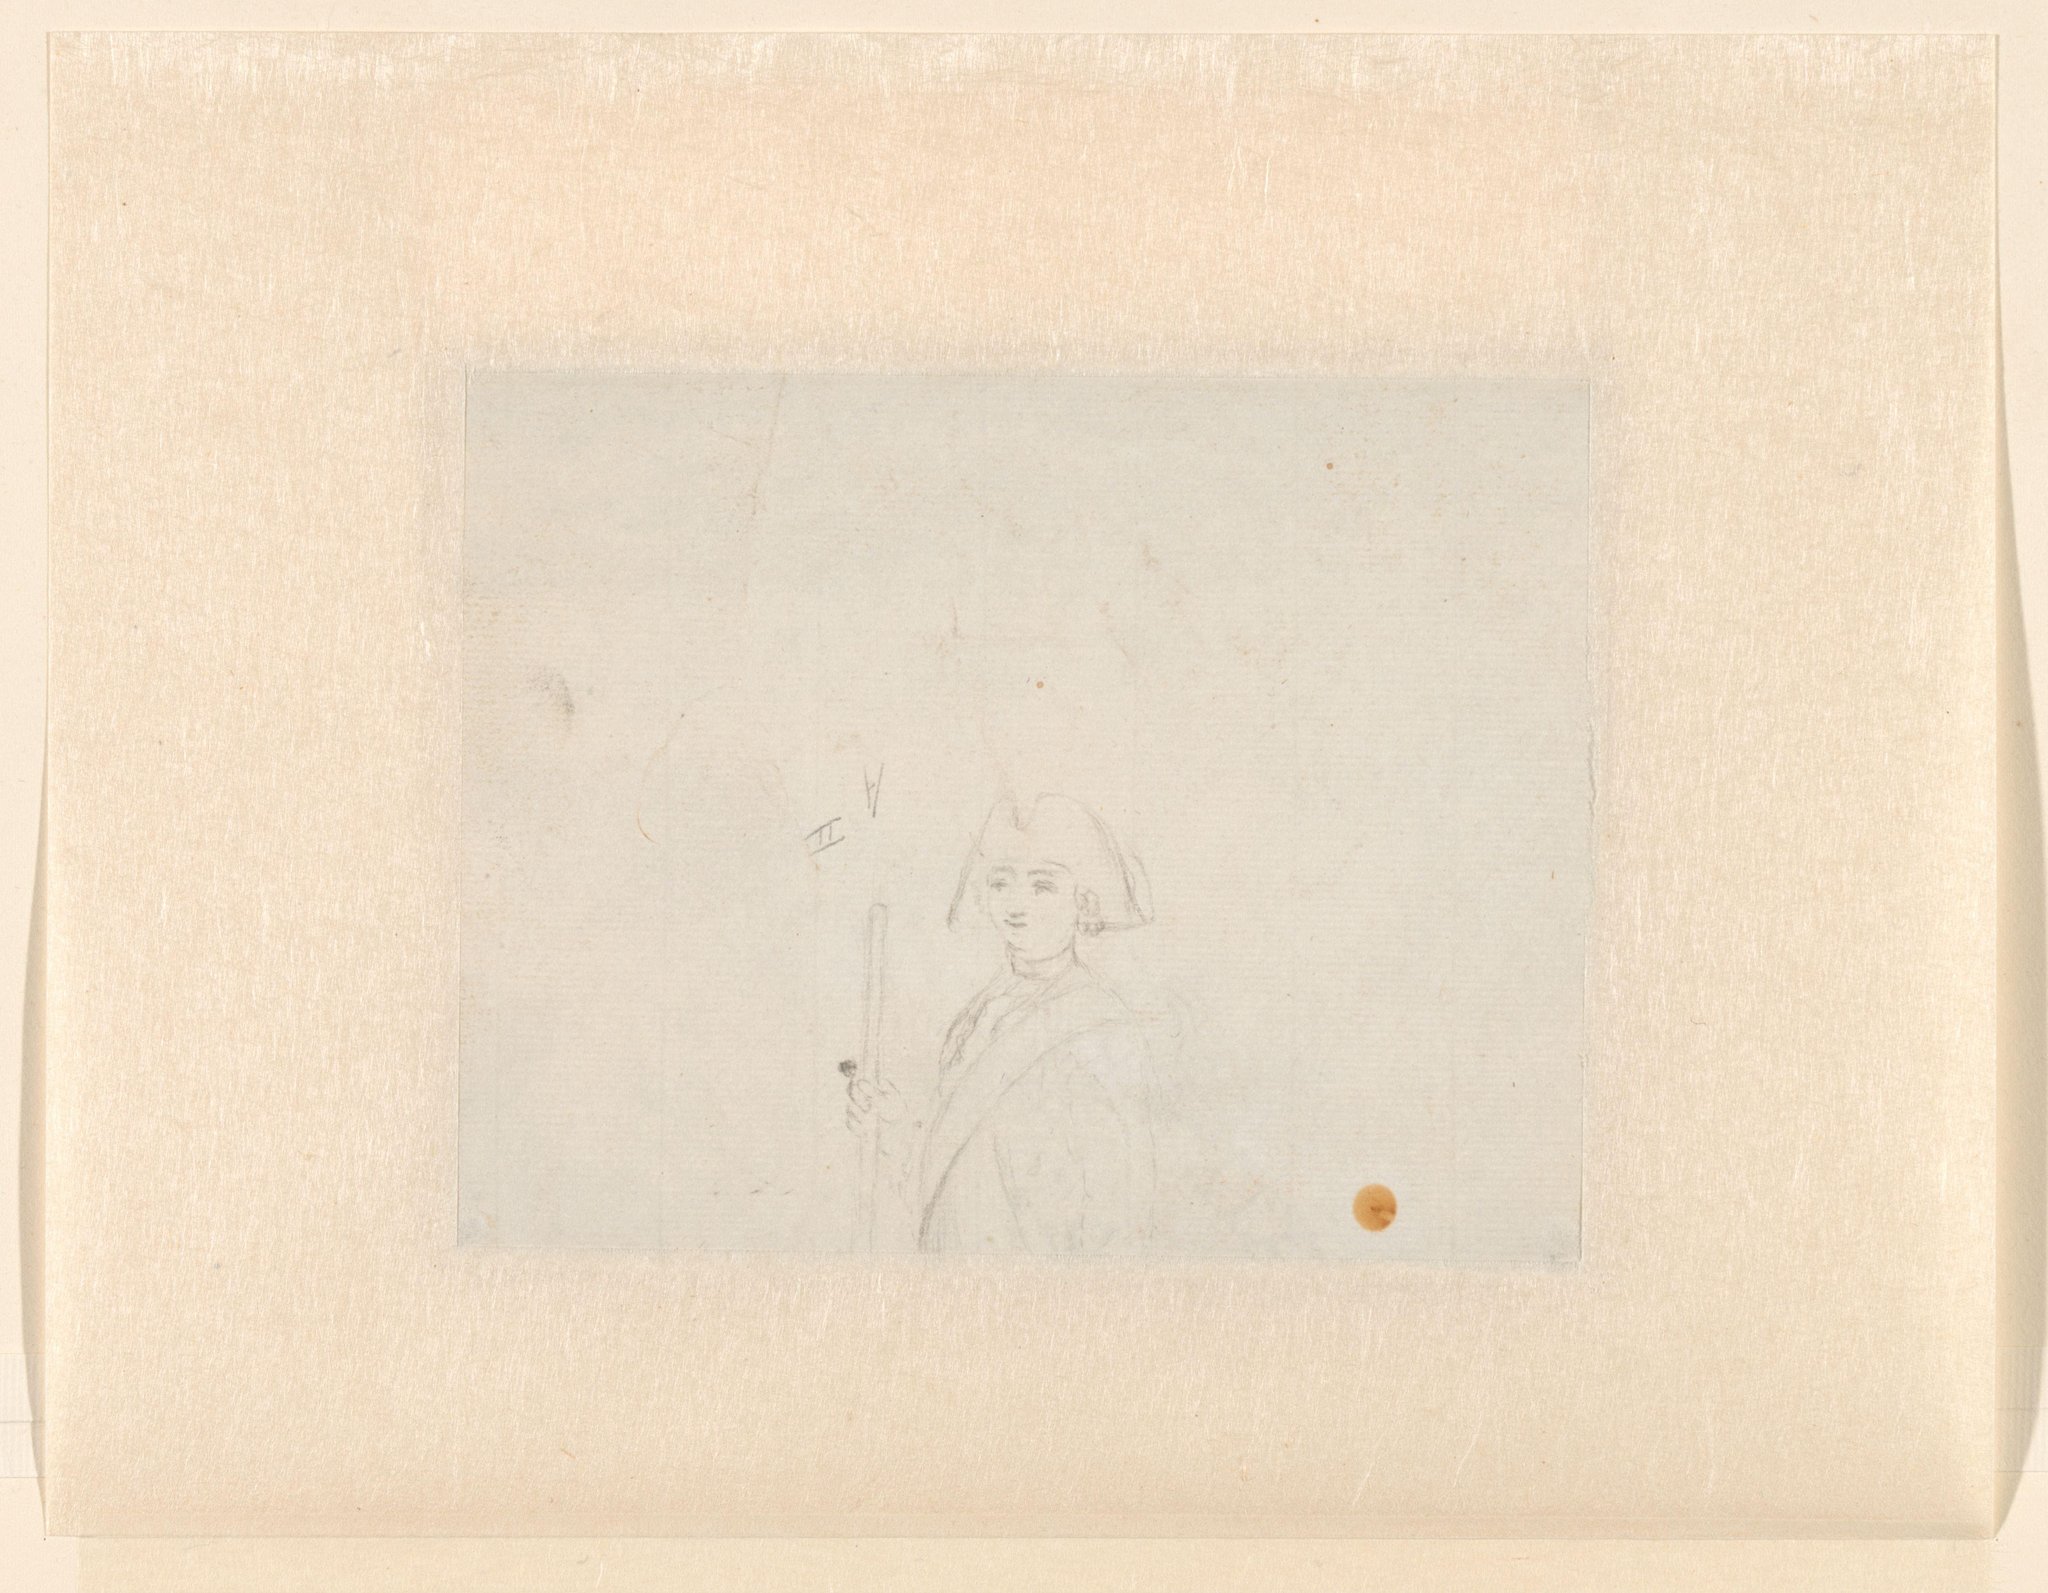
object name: drawing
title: Bovenste helft van een schets van een staande soldaat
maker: pieter idserts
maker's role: draughtsman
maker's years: 1698-1781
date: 1708-1781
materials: chalk, paper